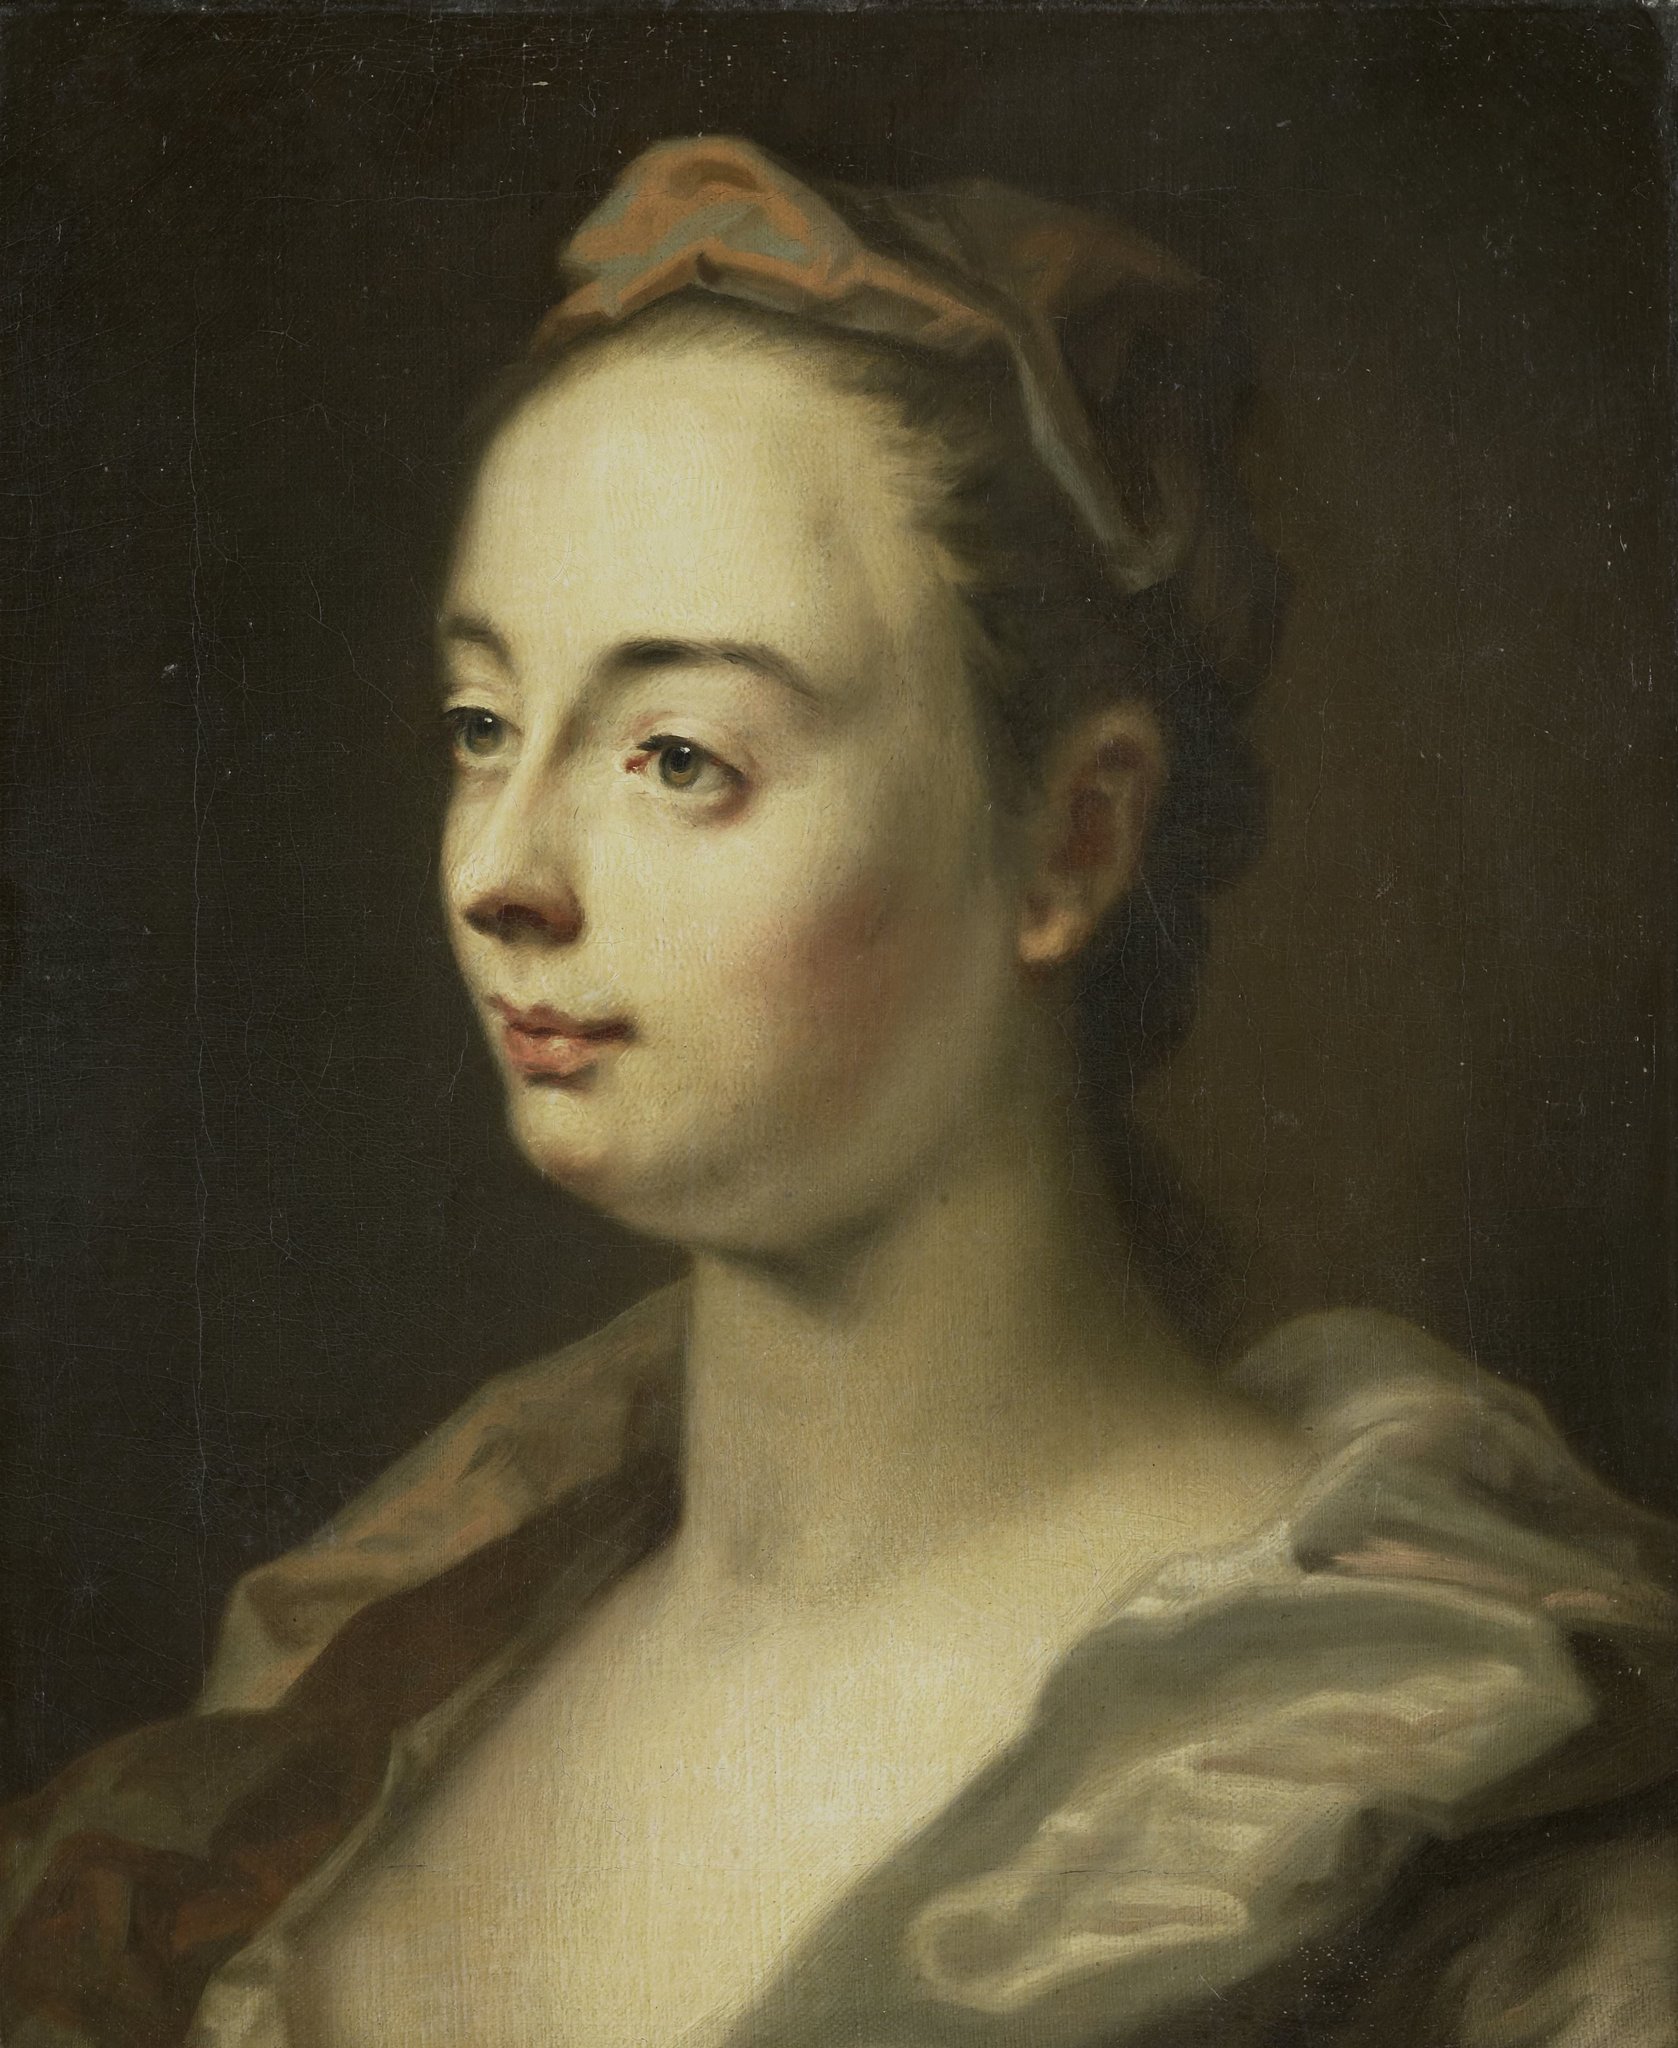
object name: painting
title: Portrait of a Woman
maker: balthasar denner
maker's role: painter, print maker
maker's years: 1685-1749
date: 1731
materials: canvas, oil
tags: historical persons not known by name - bb - woman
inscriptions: signature and date: ‘Denner. 1731’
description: Portret van een onbekende vrouw, buste naar links.